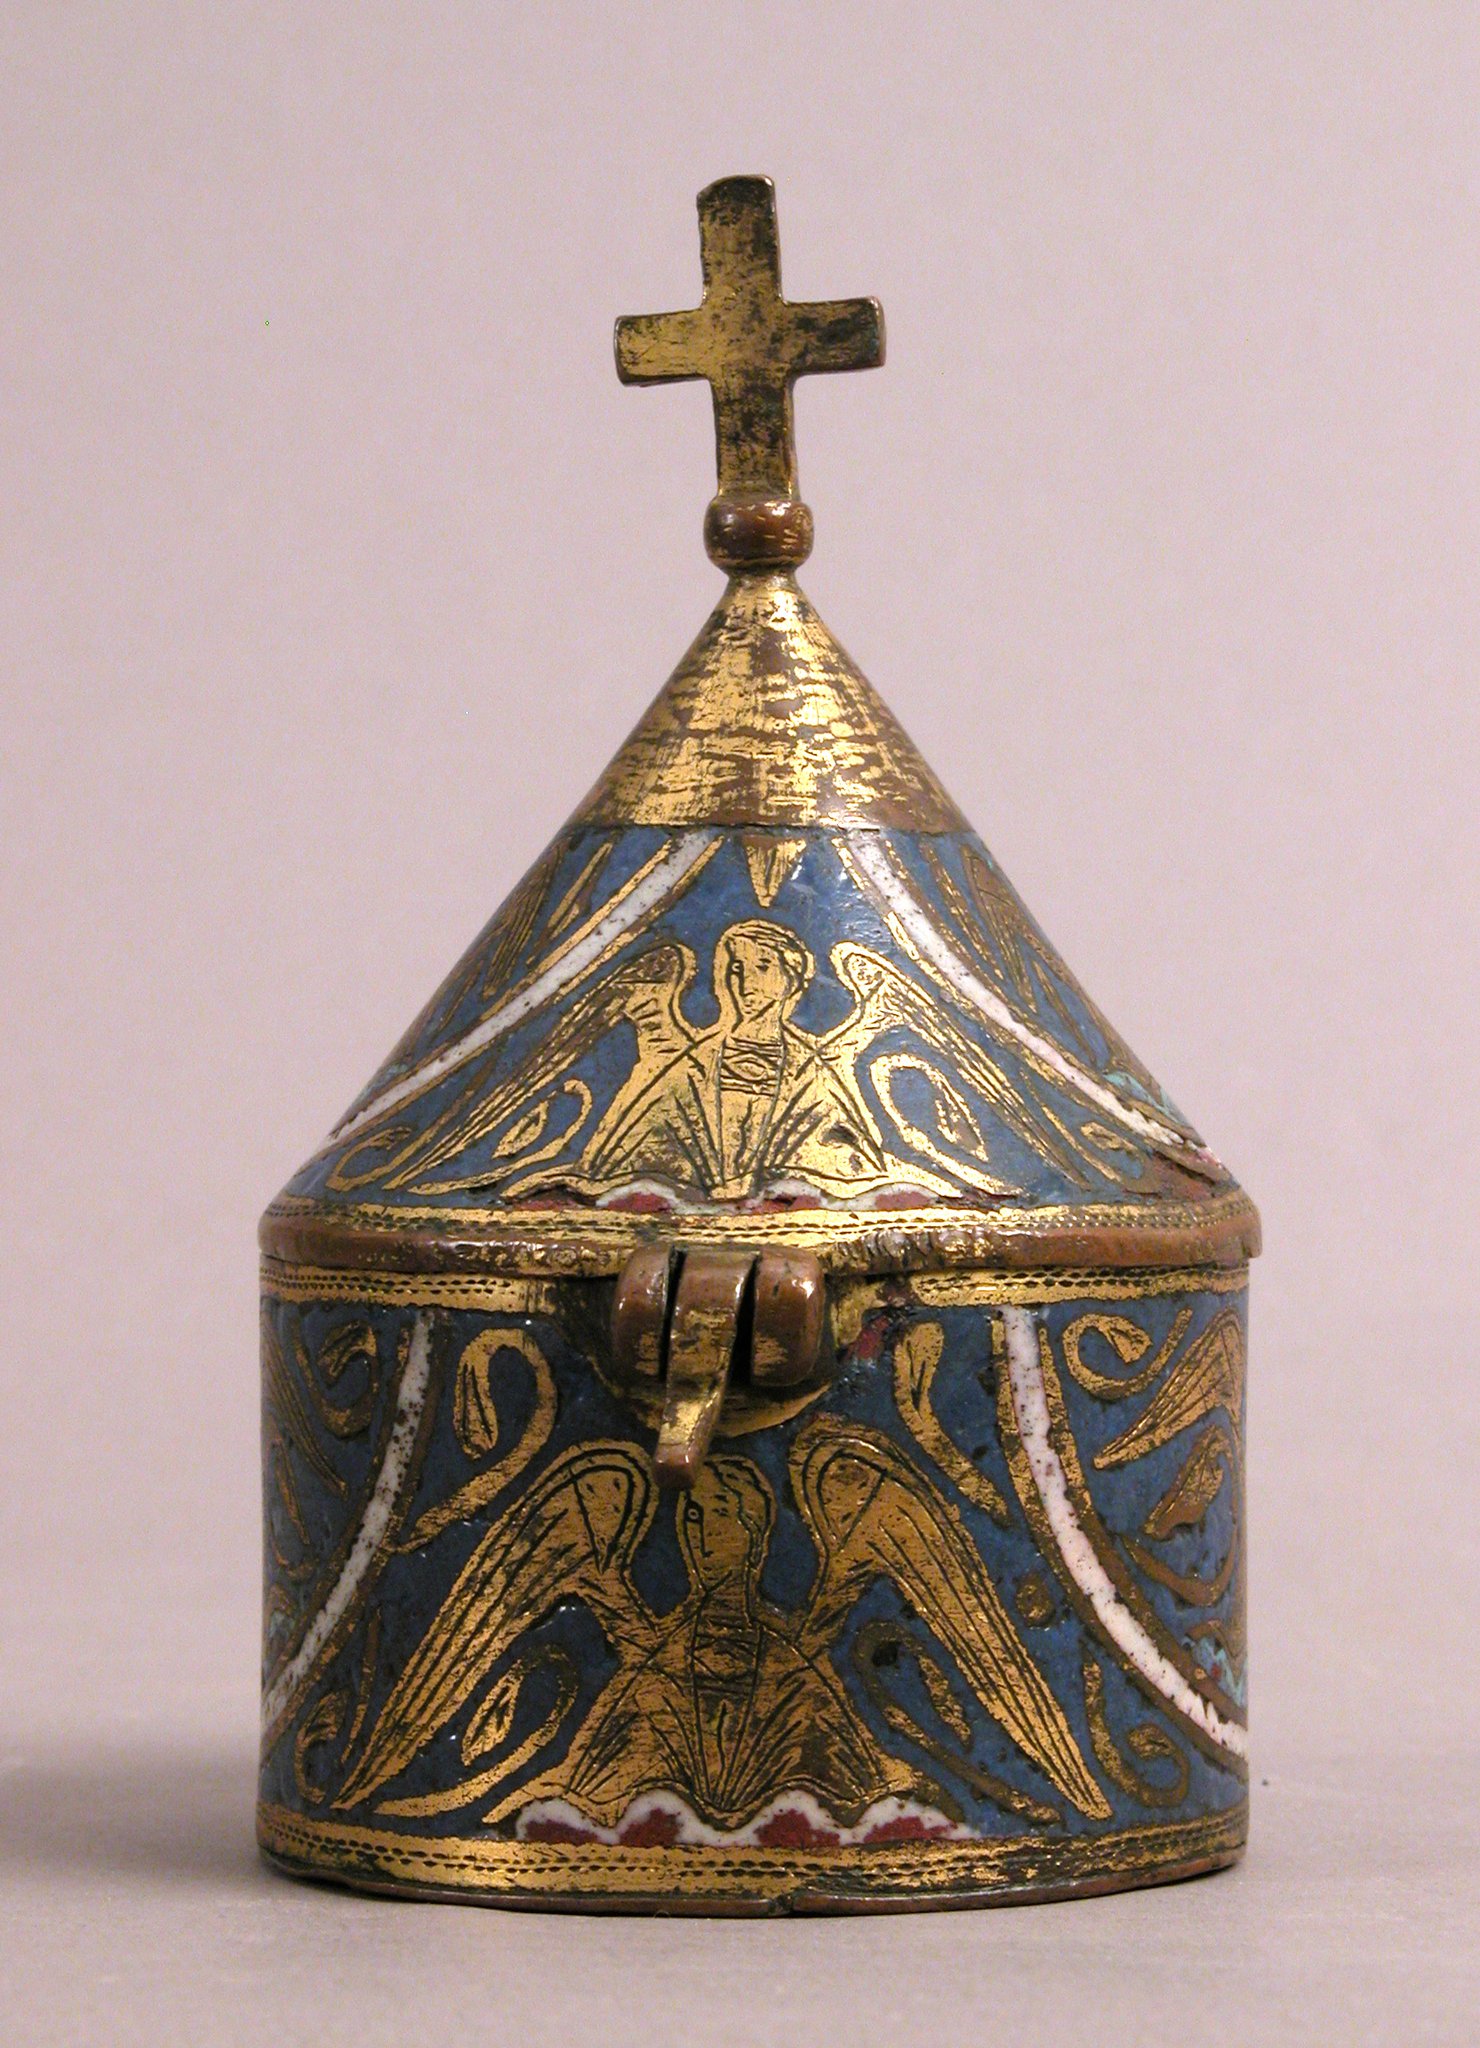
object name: pyx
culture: french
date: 1201-1300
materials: gilt copper, enamel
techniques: enamel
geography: france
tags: angels,cross